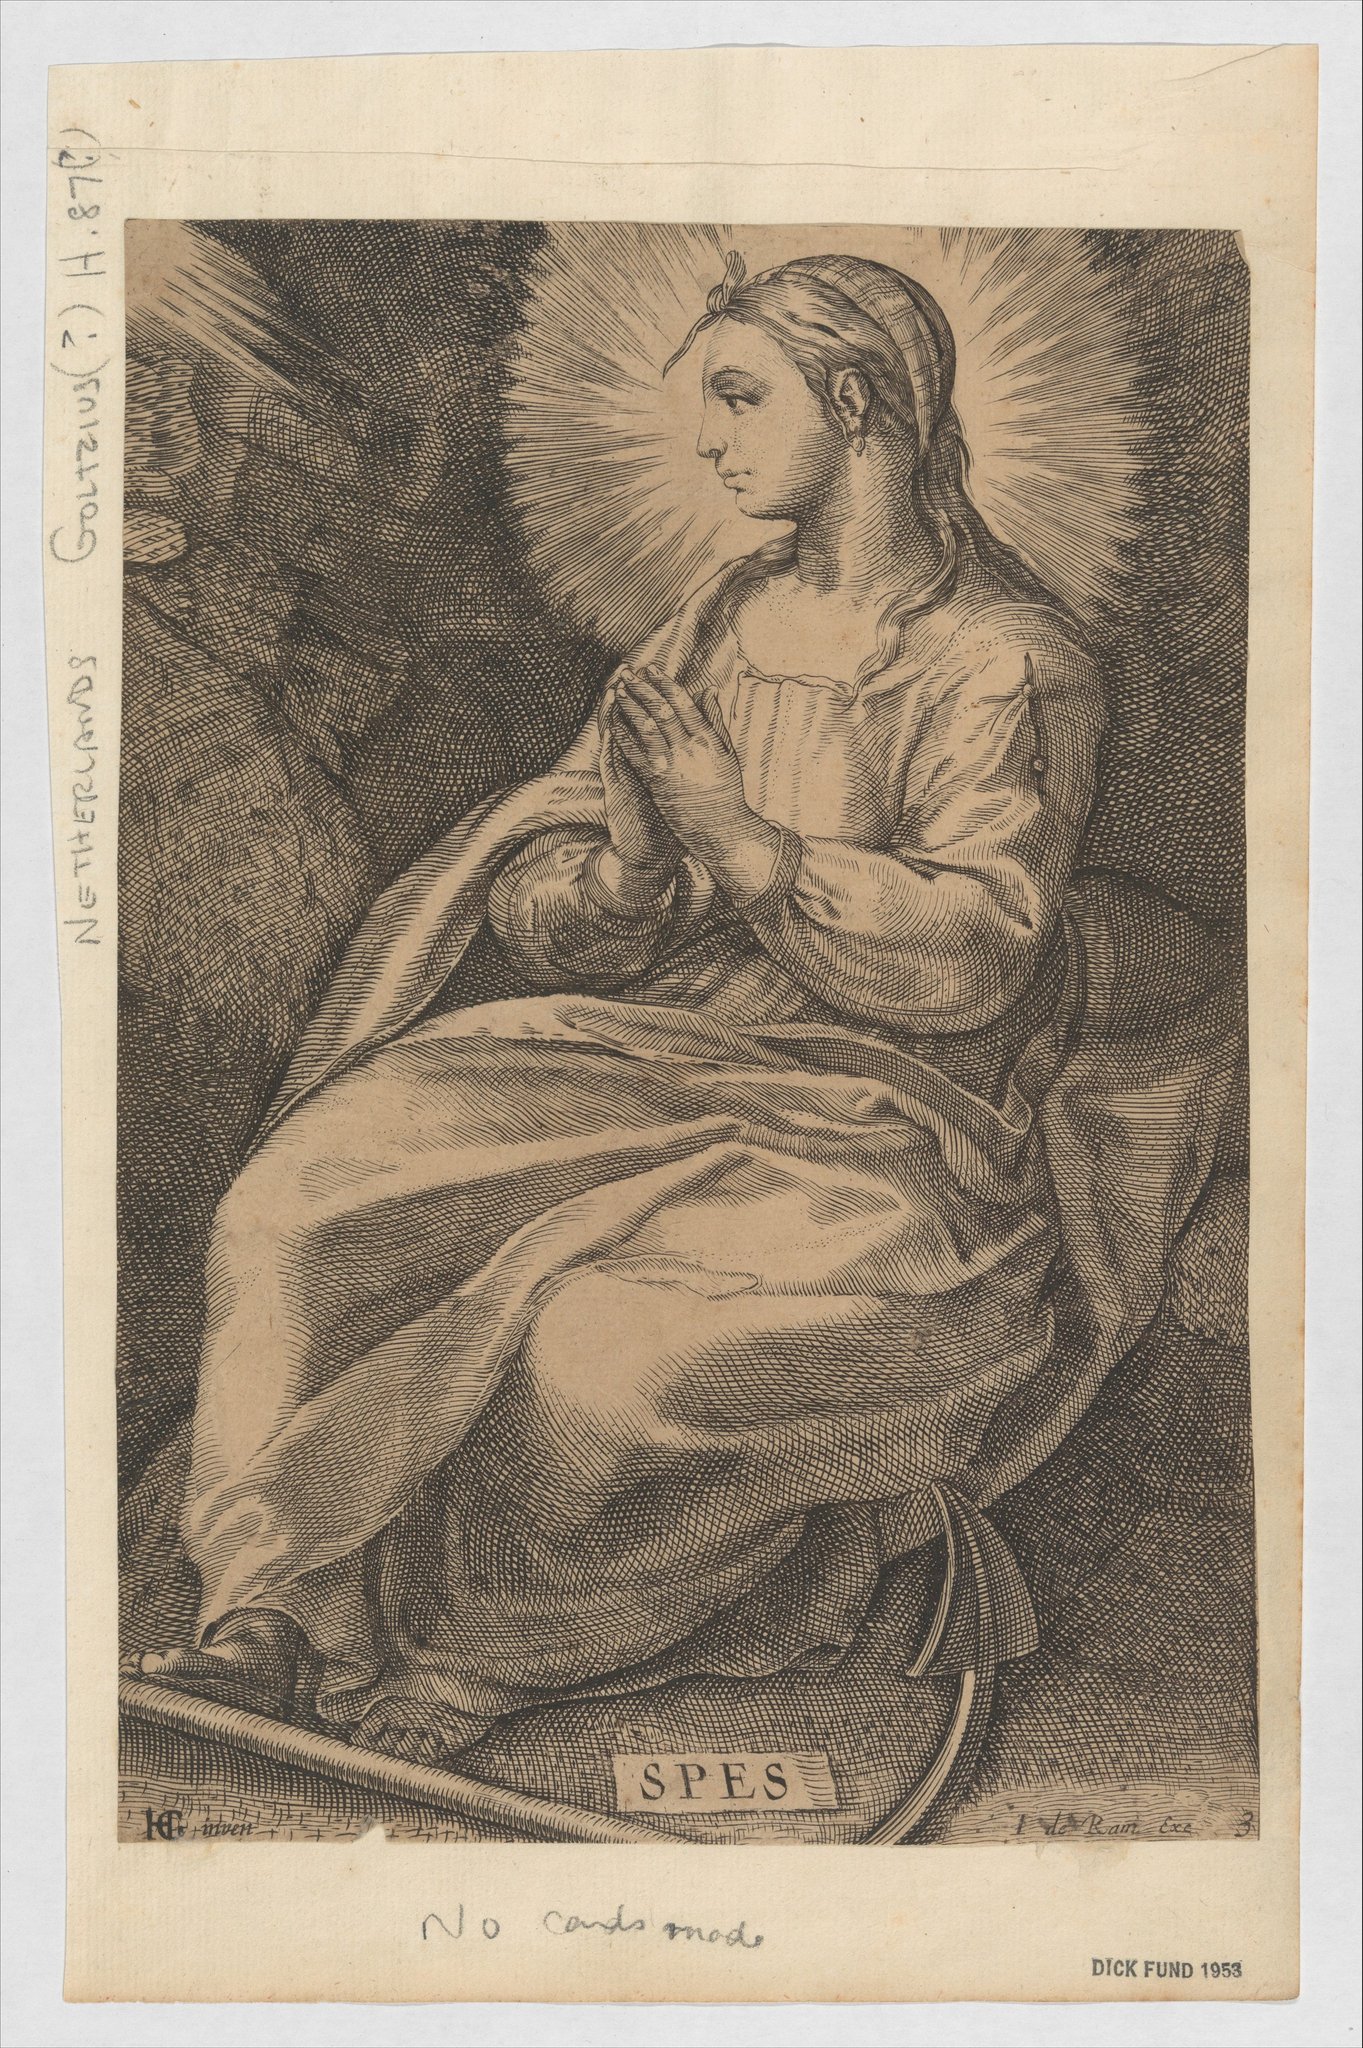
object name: print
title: Spes (copy)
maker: anonymous, dutch, 17th century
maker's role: artist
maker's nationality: dutch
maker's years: 1600-1700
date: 1667-1700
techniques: engraving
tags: women